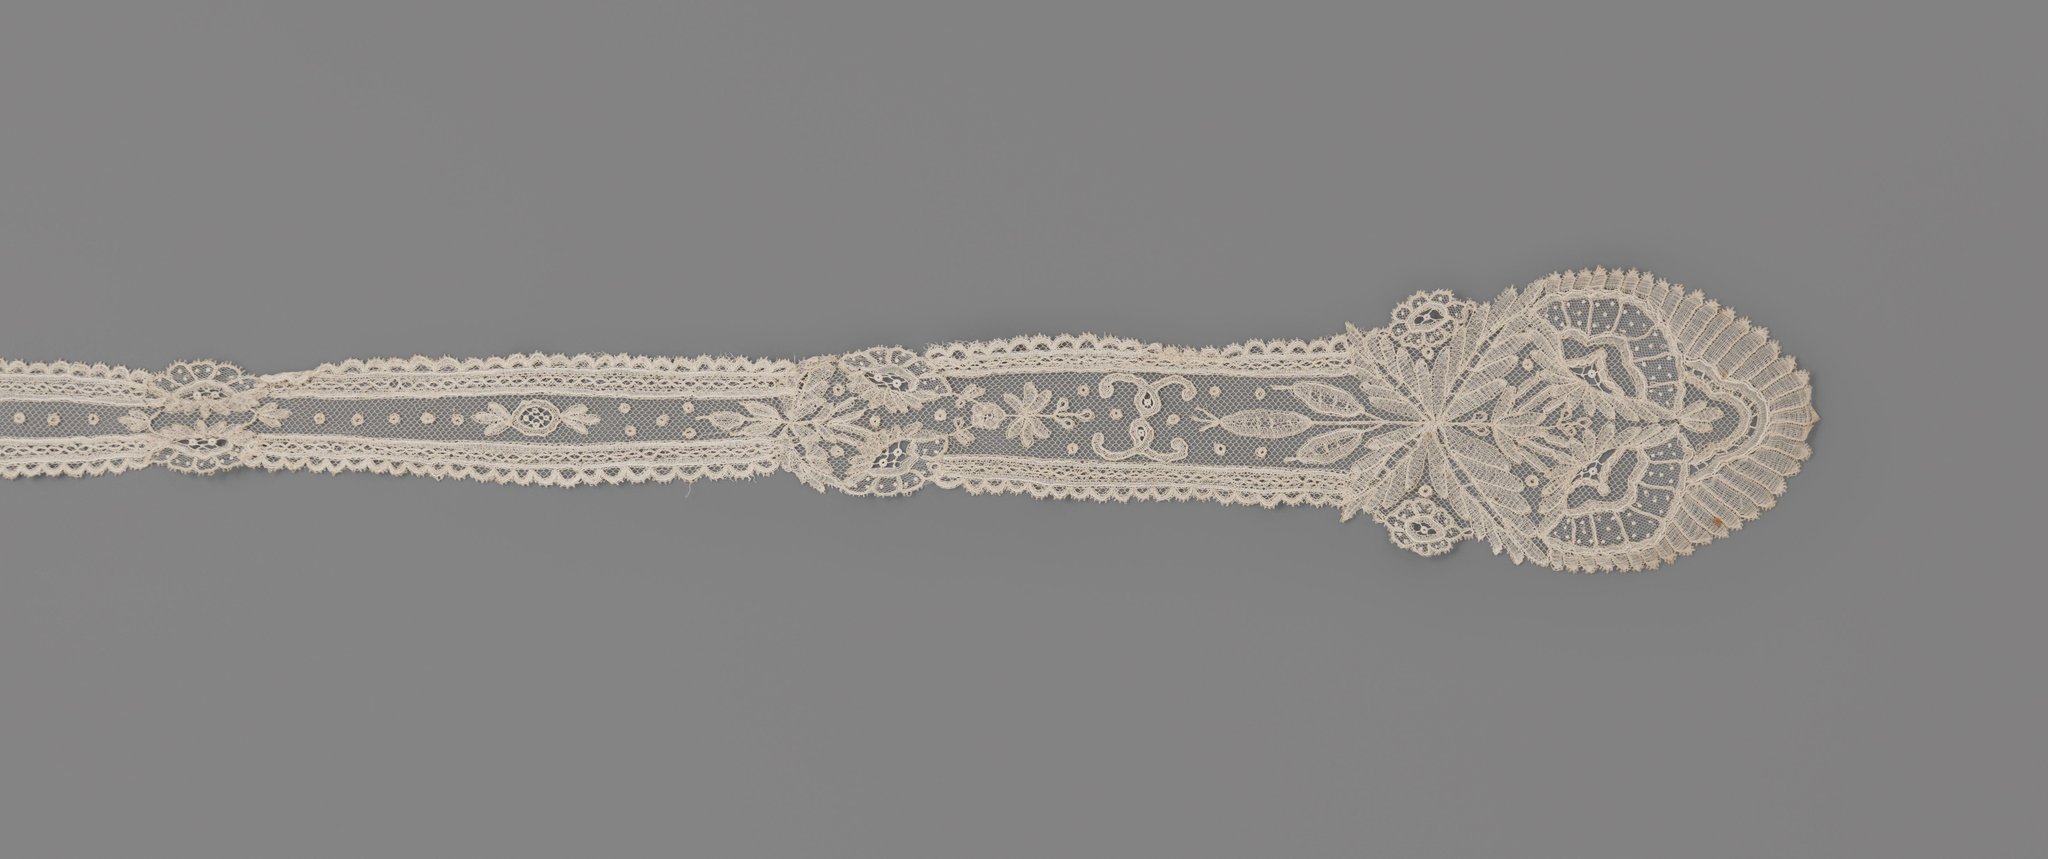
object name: womenswear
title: Strikdas van gemengde kant op machinale tule met ronde uiteinden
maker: Anonymous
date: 1880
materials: lace, fiber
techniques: lace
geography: brussels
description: Strikdas van gemengde kant op machinale tule met ronde uiteinden. De randen zijn geschulpt en gepicoteerd. De decoratie bestaat uit bladmotieven, medaillons en moesjes.